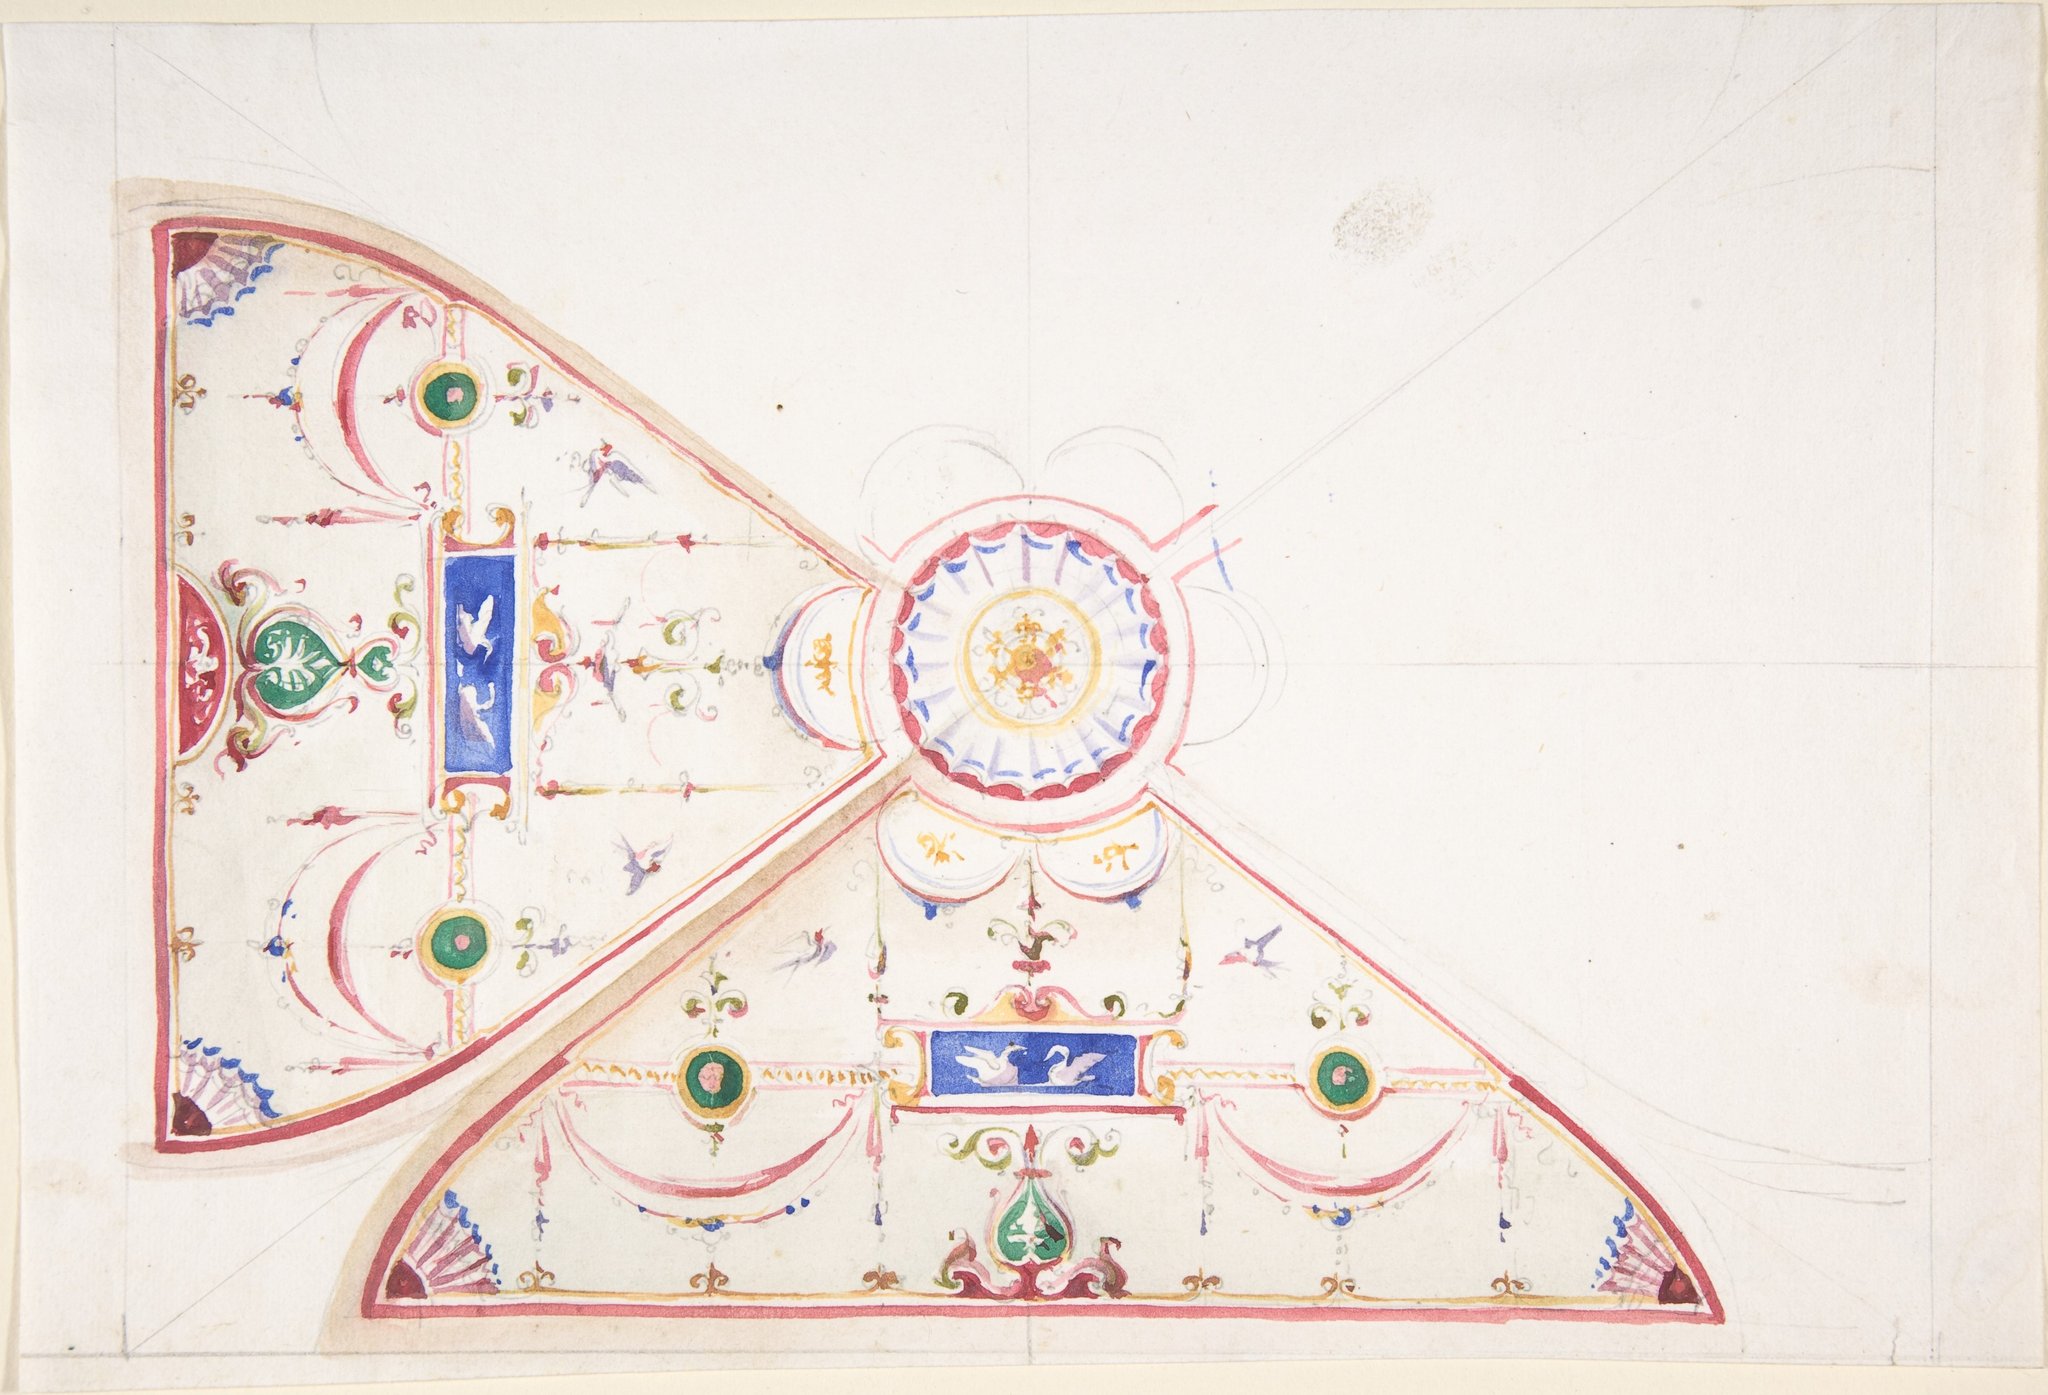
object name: drawing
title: Design for a Painted Ceiling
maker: anonymous, italian, 19th century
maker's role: artist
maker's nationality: italian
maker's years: 1800-1900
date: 1825-1875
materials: watercolor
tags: ceilings